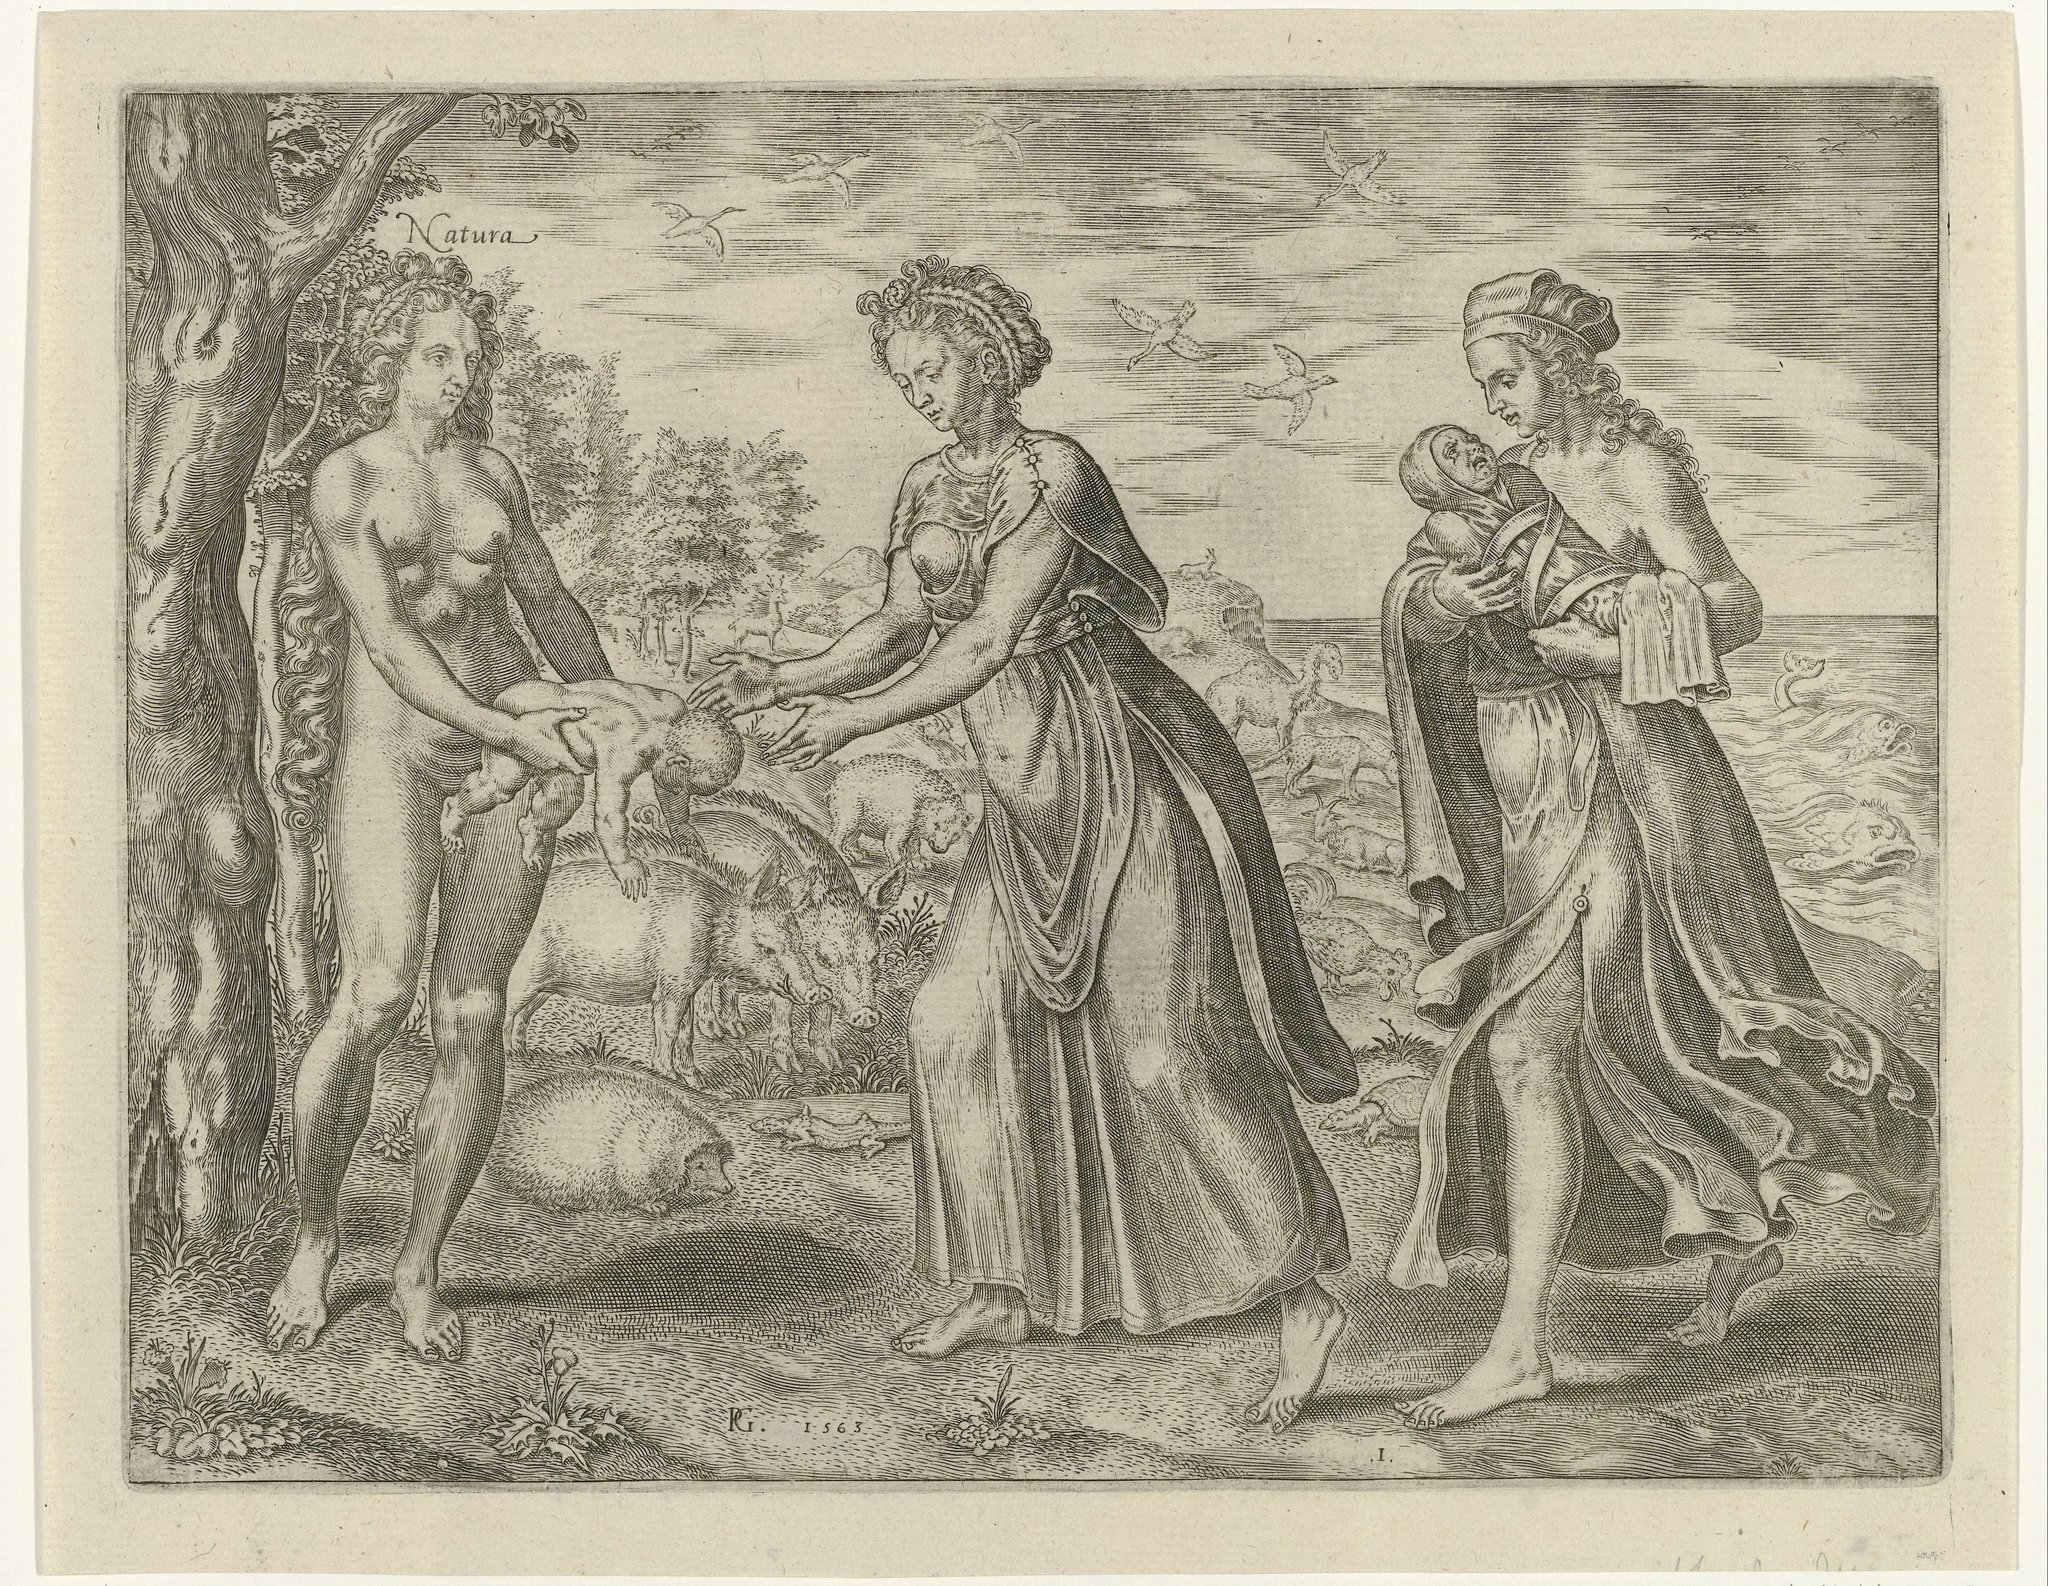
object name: print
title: Geboorte van de mens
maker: philips galle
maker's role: print maker, publisher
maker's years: 1537-1612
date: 1563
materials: paper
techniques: engraving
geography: haarlem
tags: 'natura' (allegorical figure or scene; or as diana of ephesus, with many breasts); 'natura' (ripa), mother and baby or young child, infant, baby, baby in swaddling clothes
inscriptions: collector's mark: Lugt 2228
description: De veelborstige Natuur (Natura) geeft een naakte zuigeling aan zijn moeder. Het kind wordt door een andere vrouw stevig ingezwachteld in doeken. In de achtergrond allerlei dieren, die van al vanaf de geboorte door hun huid zijn beschermd. Alleen de mens wordt naakt en onbeschermd geboren. De prent is deel van een serie over de ellende van het menselijk bestaan.